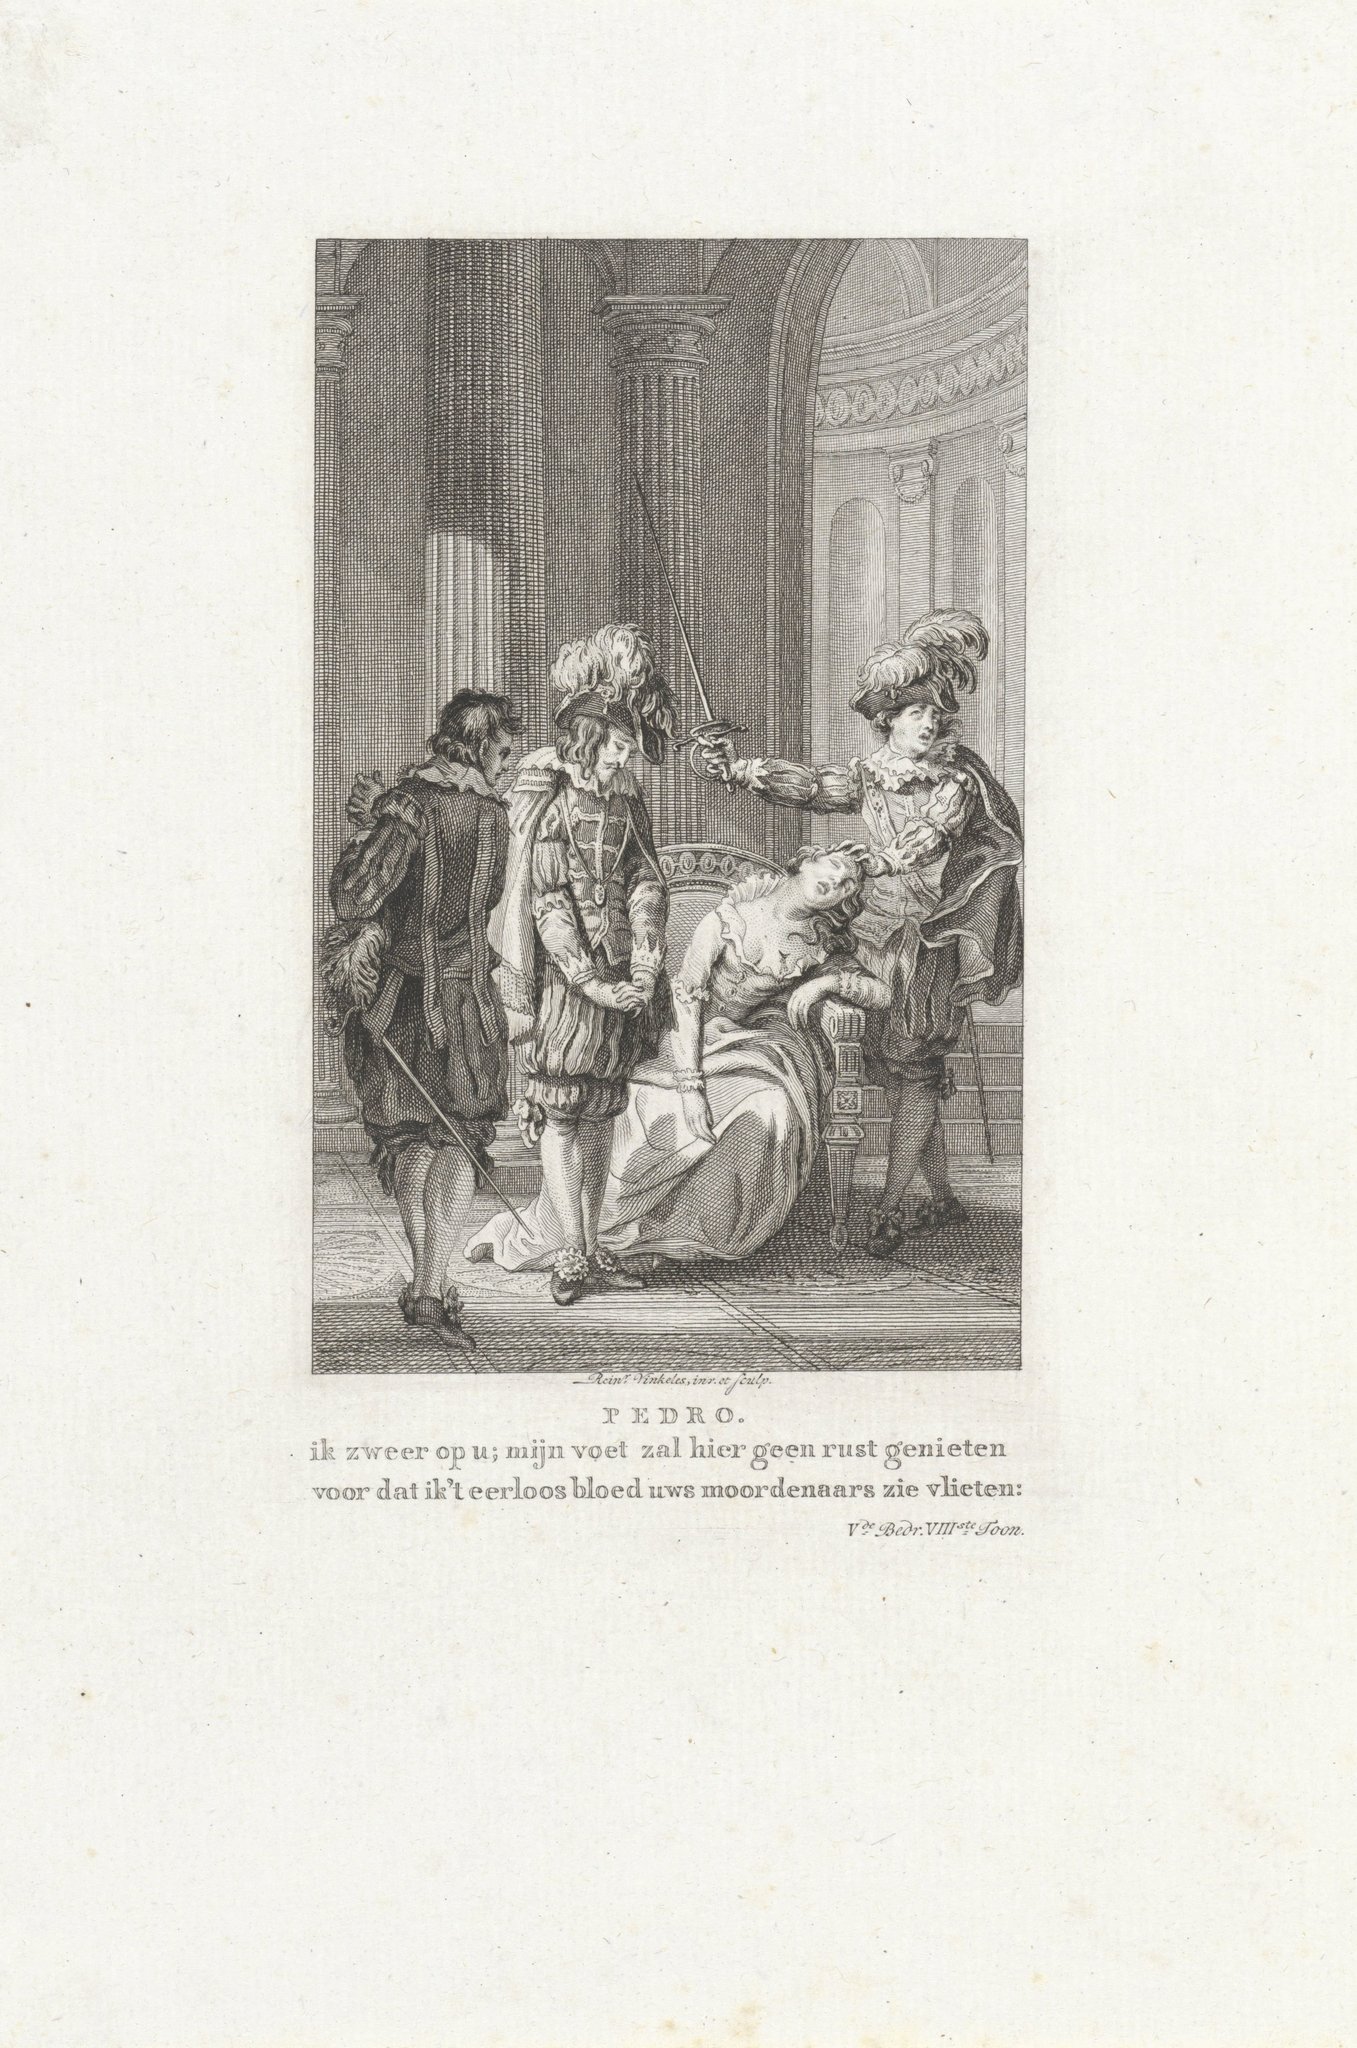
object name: print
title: Pedro trekt zijn lans om de moord op Ines te wreken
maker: reinier vinkeles (i)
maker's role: draughtsman, print maker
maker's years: 1741-1816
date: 1793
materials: paper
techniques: engraving, etching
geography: amsterdam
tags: violent death by weapon, (feith, ines de castro) specific works of literature (with author, title), blood-revenge, vendetta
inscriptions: collector's mark: Lugt 240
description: Illustratie voor het toneelstuk 'Ines de Castro' van Rhijnvis Feith, waarop Pedro zijn lans trekt om de moord op Ines te wreken.